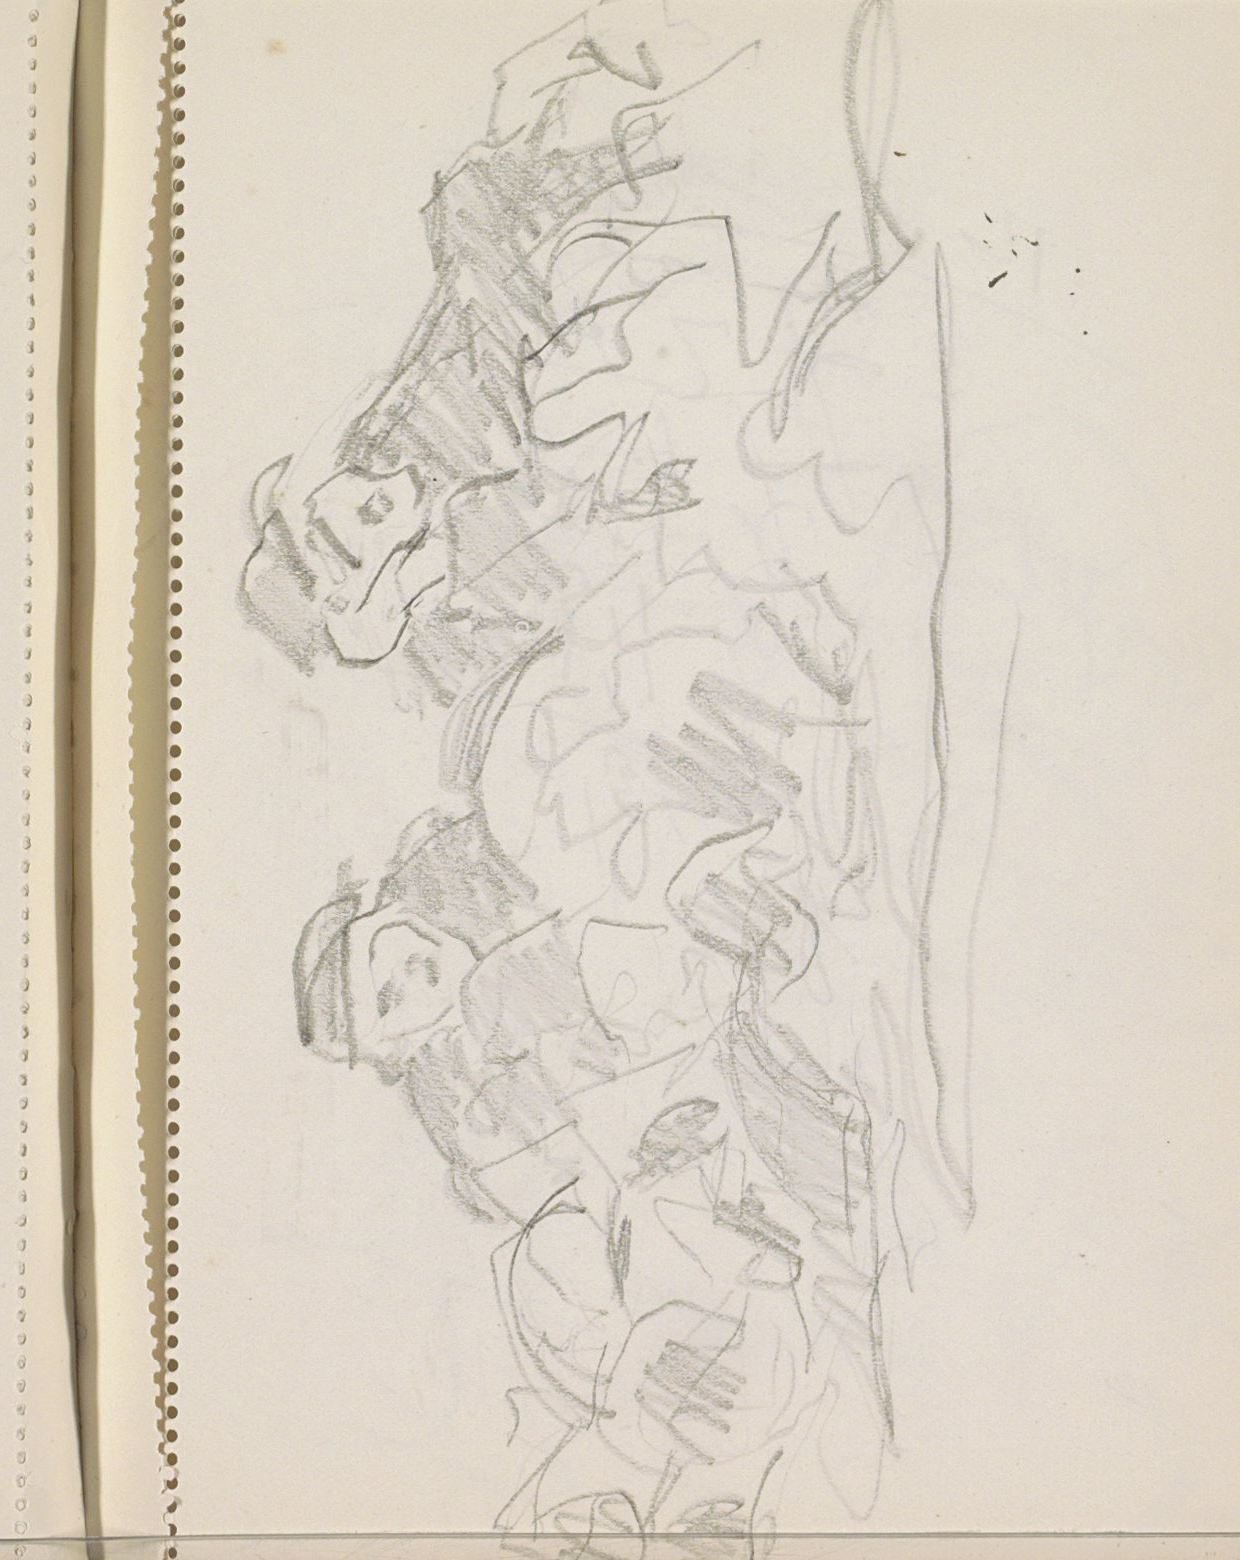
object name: sketchbook leaf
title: Twee liggende mannen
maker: reijer stolk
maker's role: draughtsman, print maker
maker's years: 1896-1945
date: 1906-1945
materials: paper, pencil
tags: lying figure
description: De mannen liggen tussen voorwerpen. Blad 39 recto uit een schetsboek met 42 bladen.